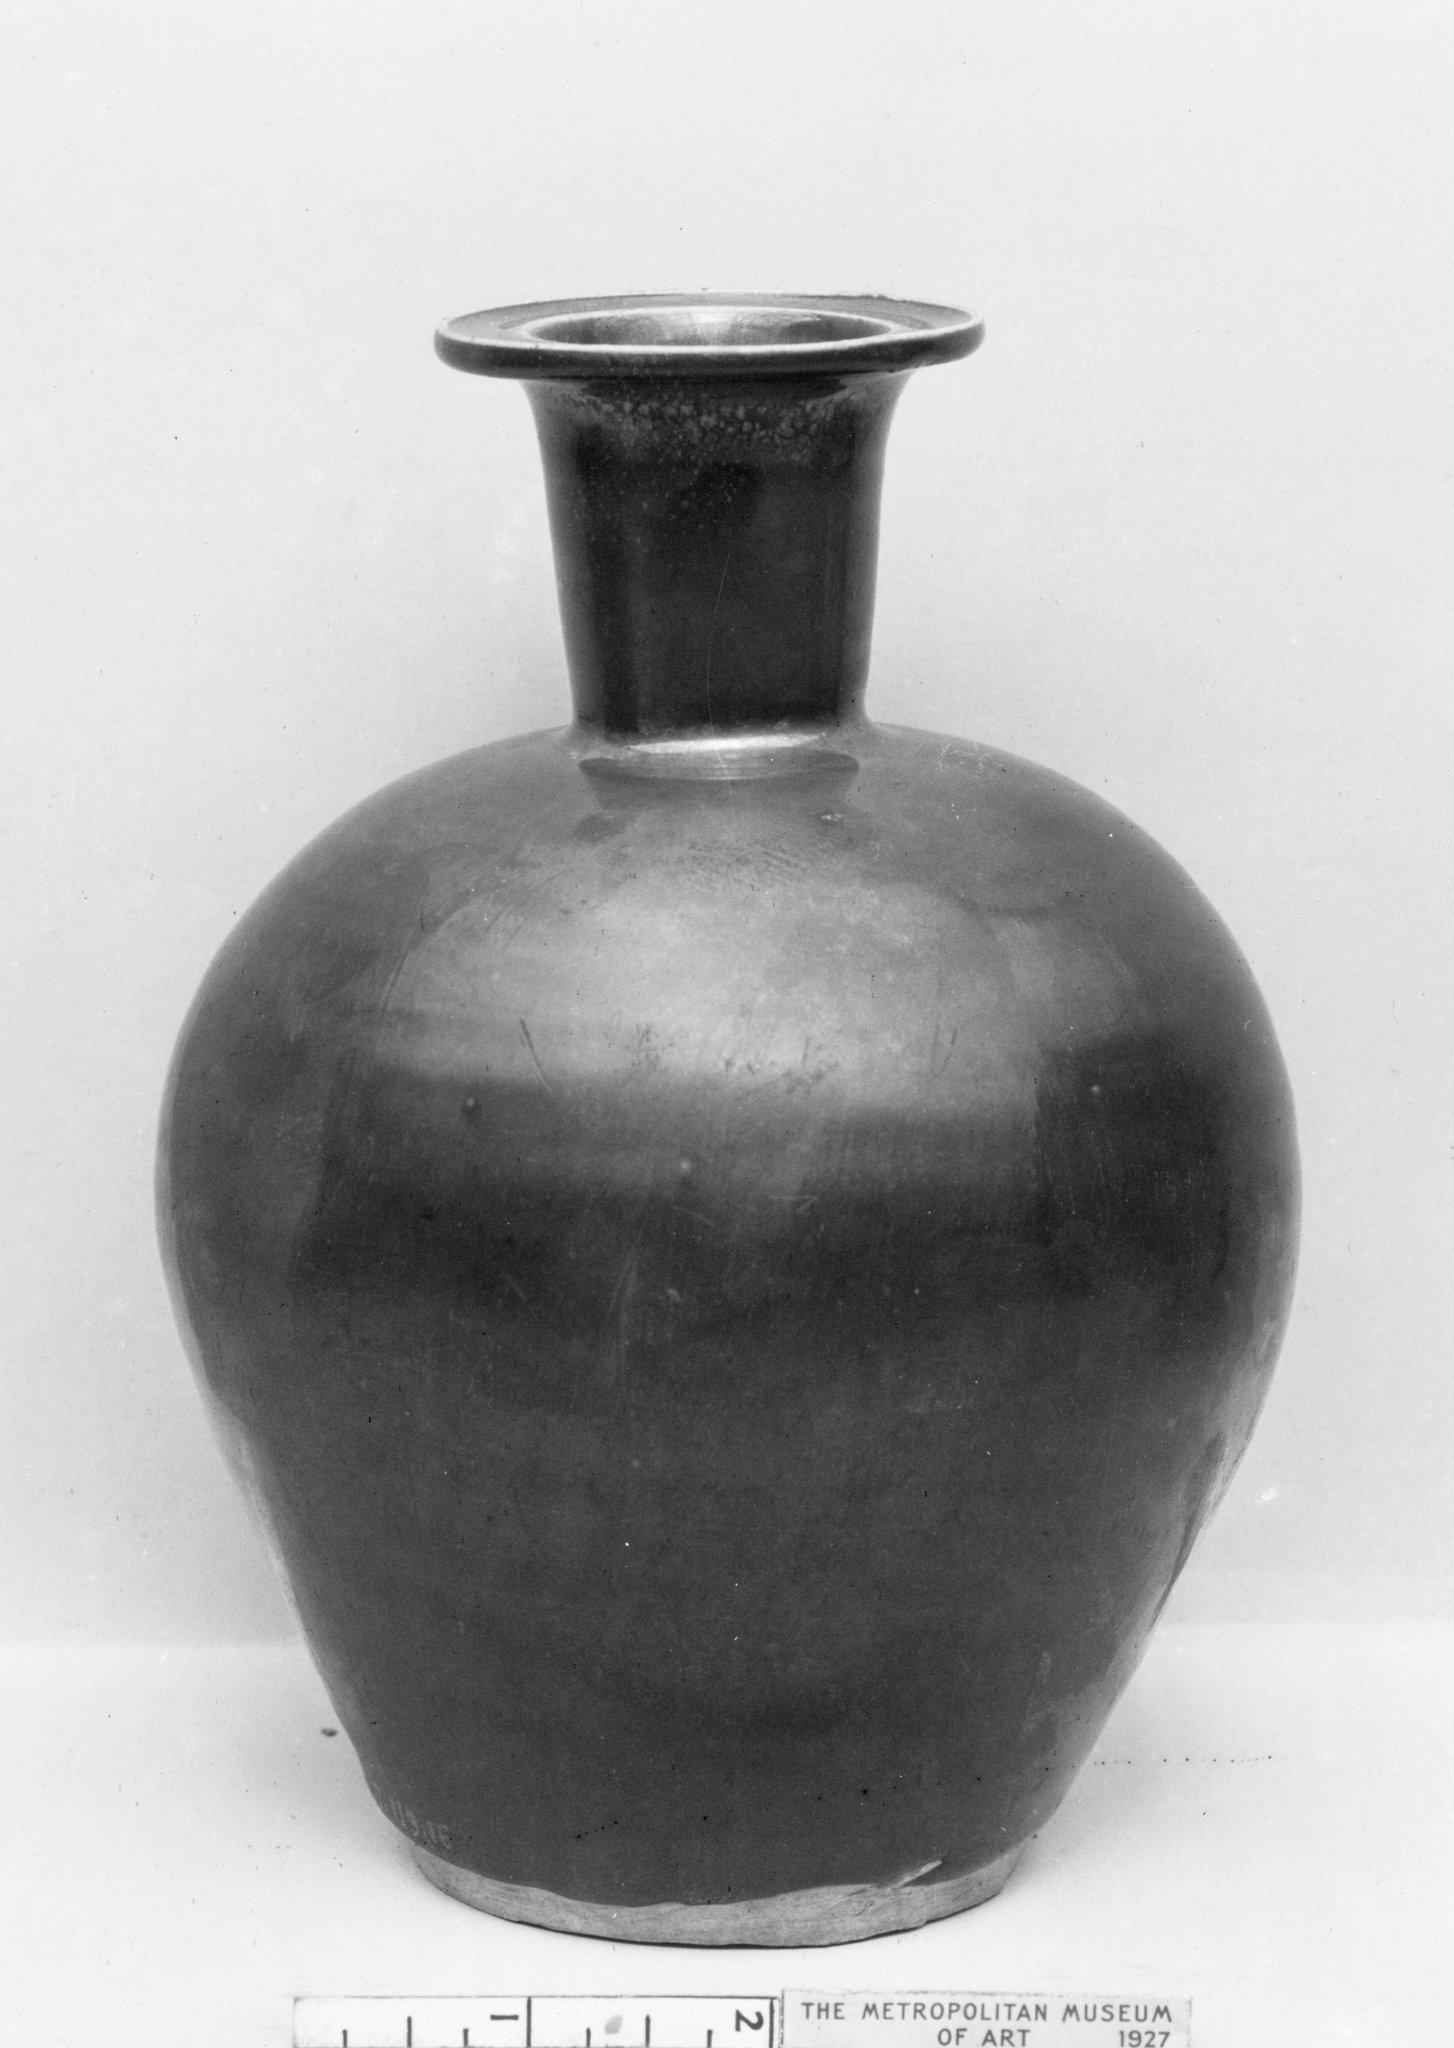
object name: bottle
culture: chinese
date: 1001-1200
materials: glaze